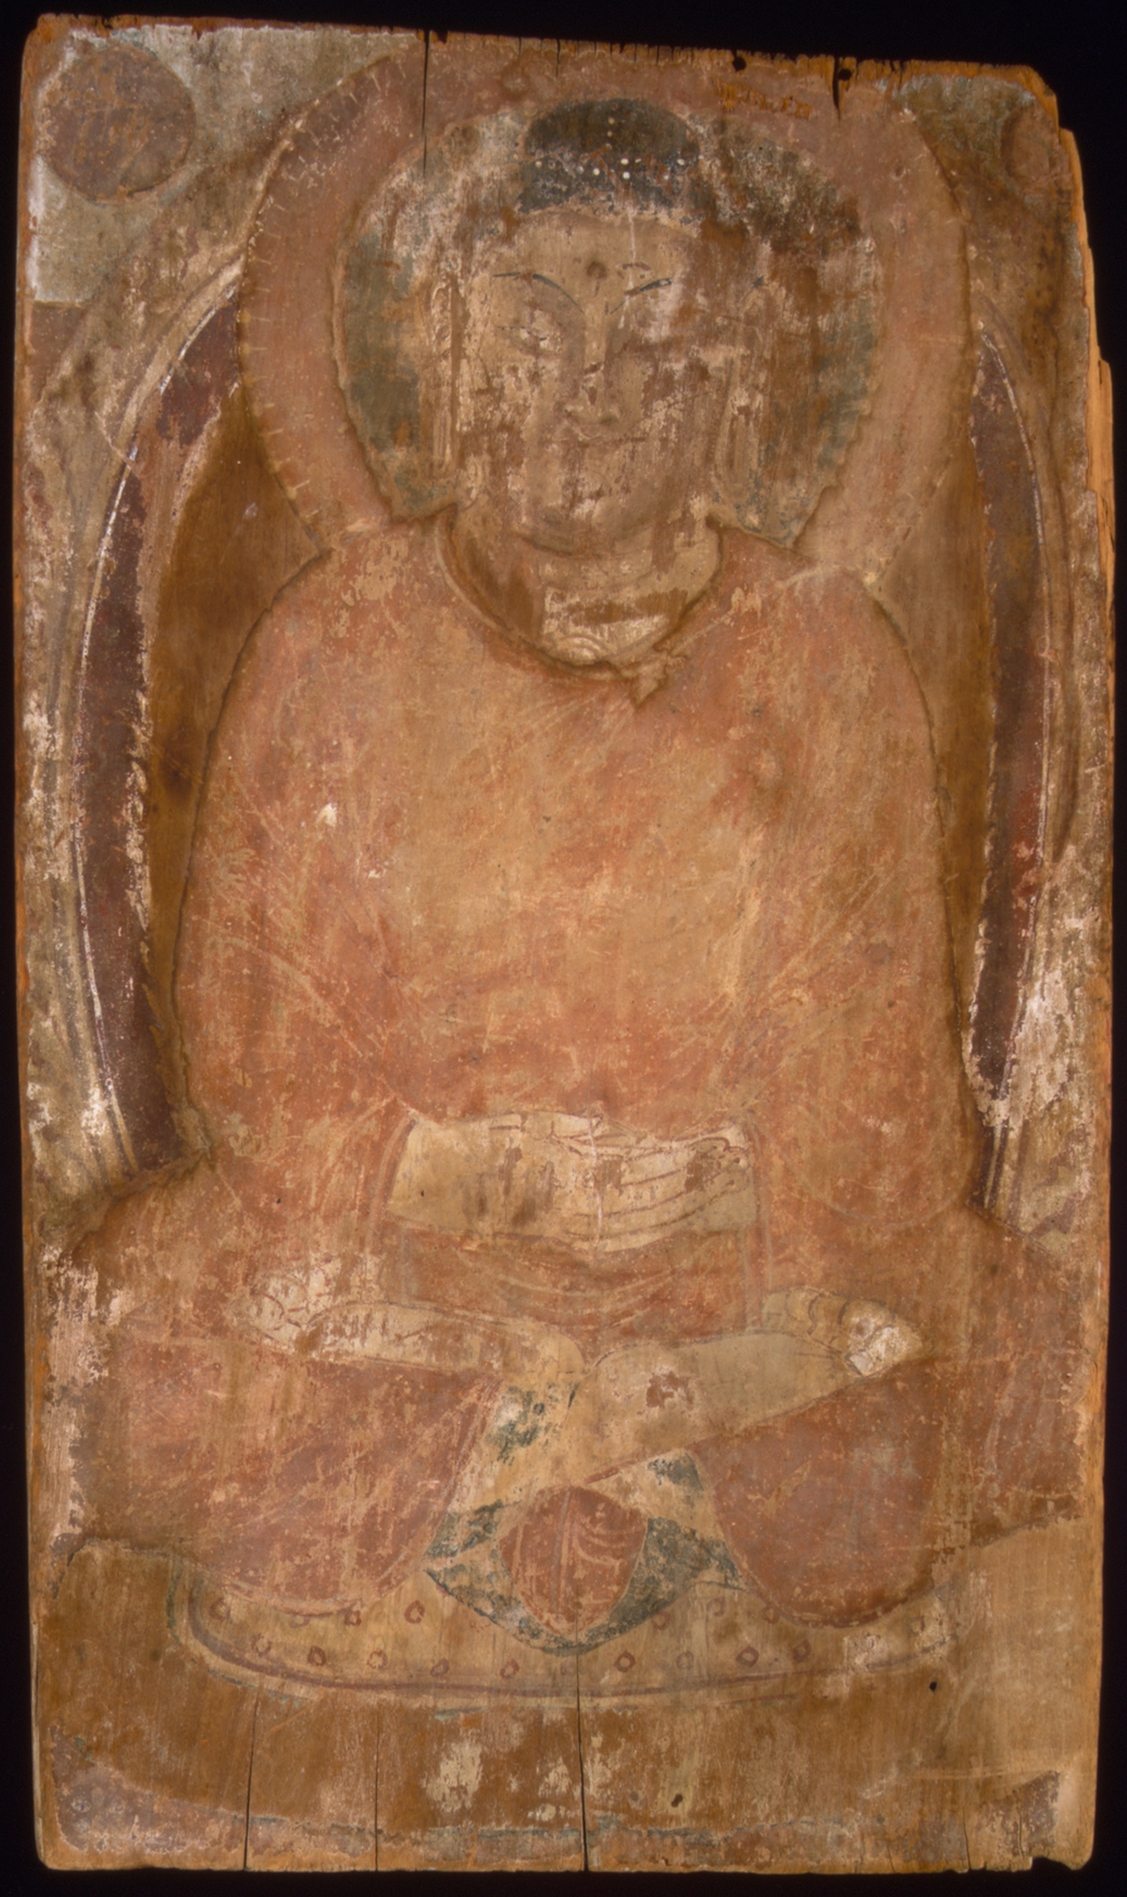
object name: wall painting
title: Buddha with a Halo and Flaming Body Mandorla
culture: chinese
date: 501-700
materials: pigment, wood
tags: buddhism,buddha